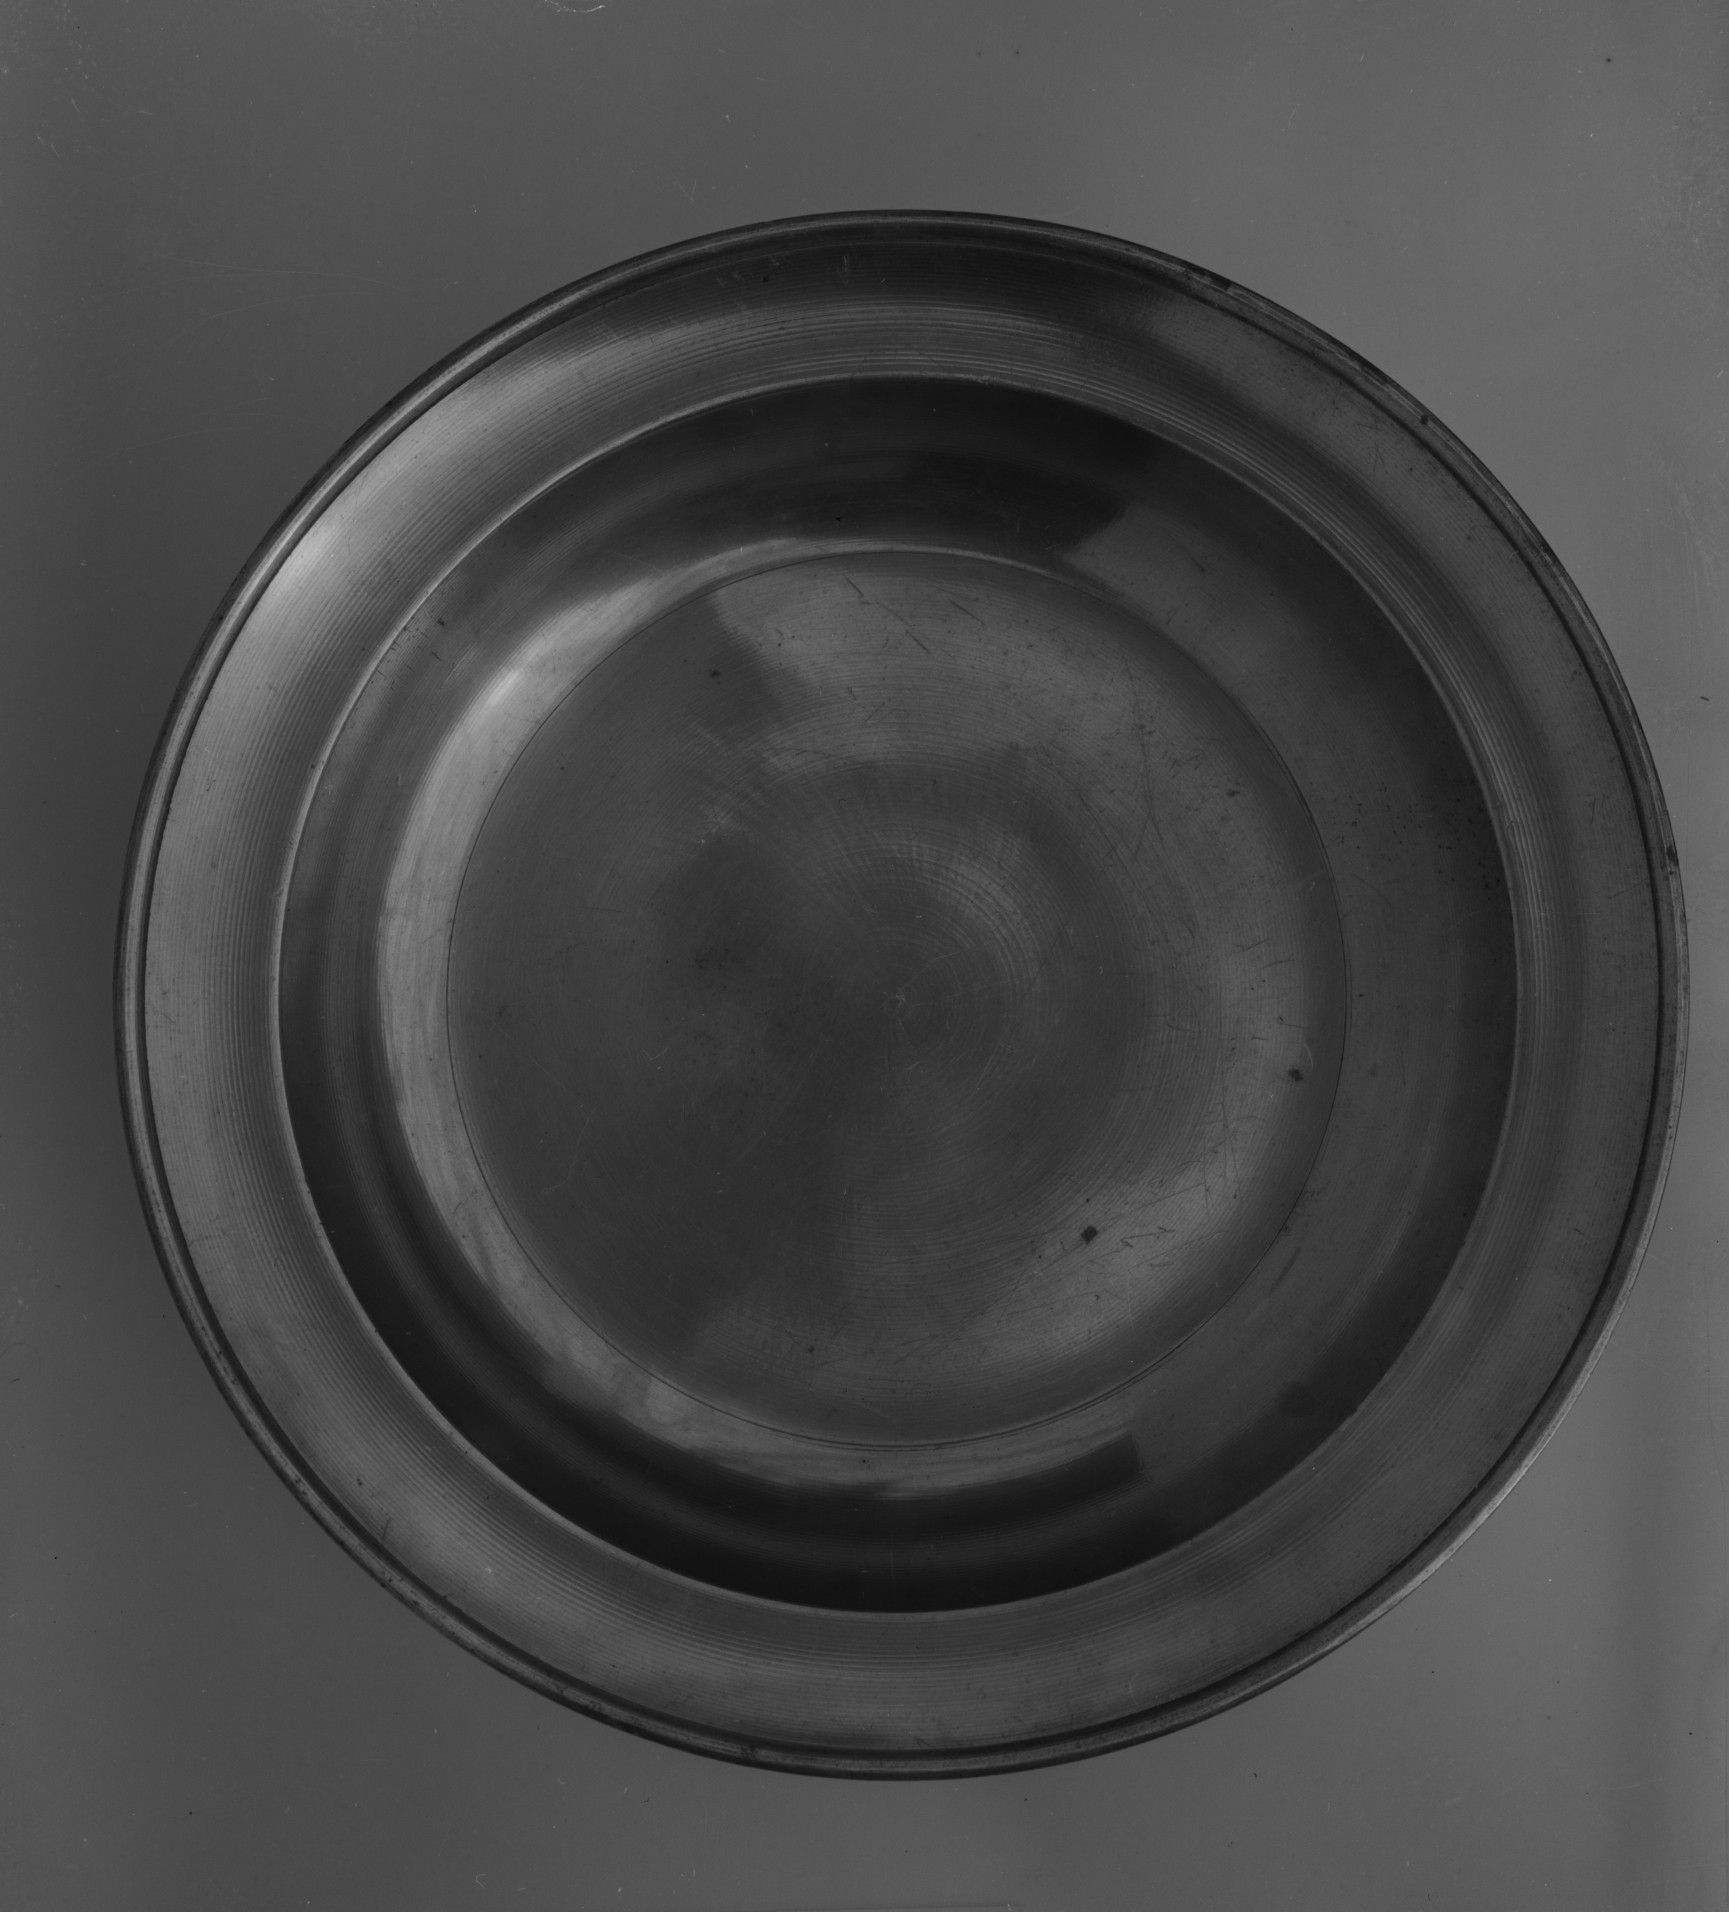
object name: dish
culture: american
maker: ashbil griswold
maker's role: maker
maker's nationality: american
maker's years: 1784-1853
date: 1807-1834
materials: pewter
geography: united states